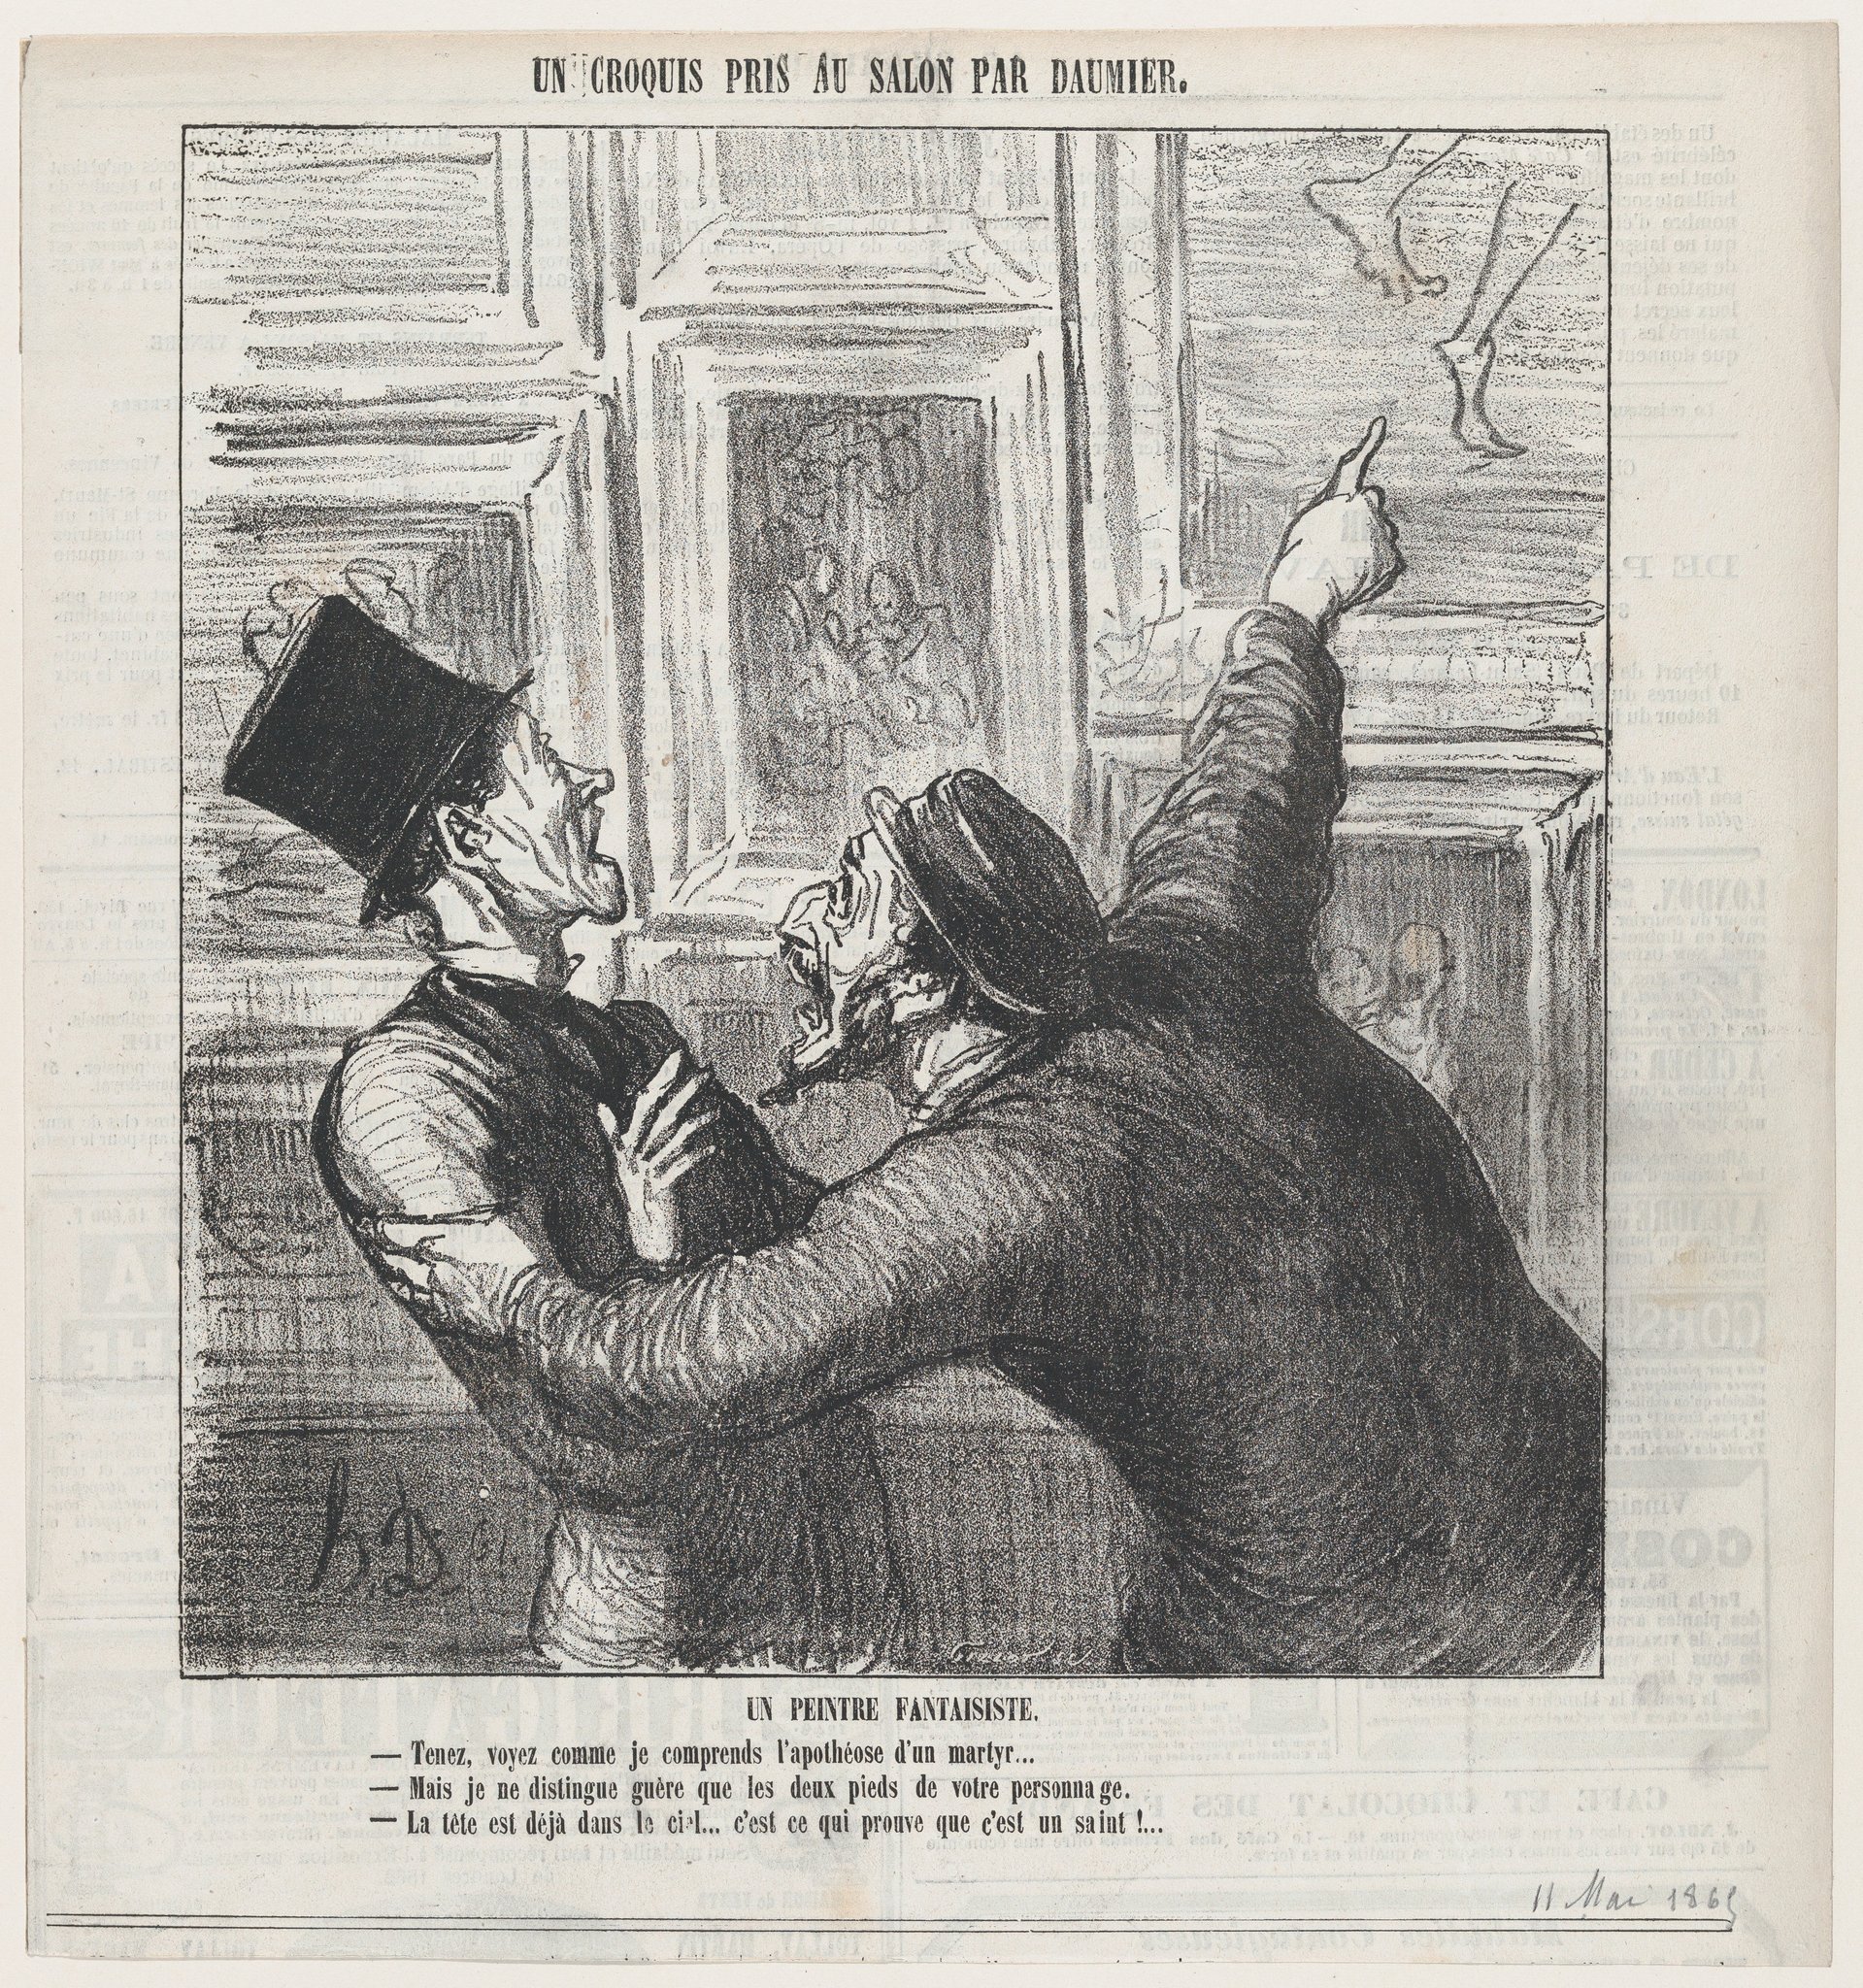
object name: print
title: A fantastic painter, from 'A sketch from the Salon,' published in Le Charivari, May 11, 1865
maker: honoré daumier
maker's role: artist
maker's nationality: french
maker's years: 1808-1879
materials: paper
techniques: lithograph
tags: satire,men